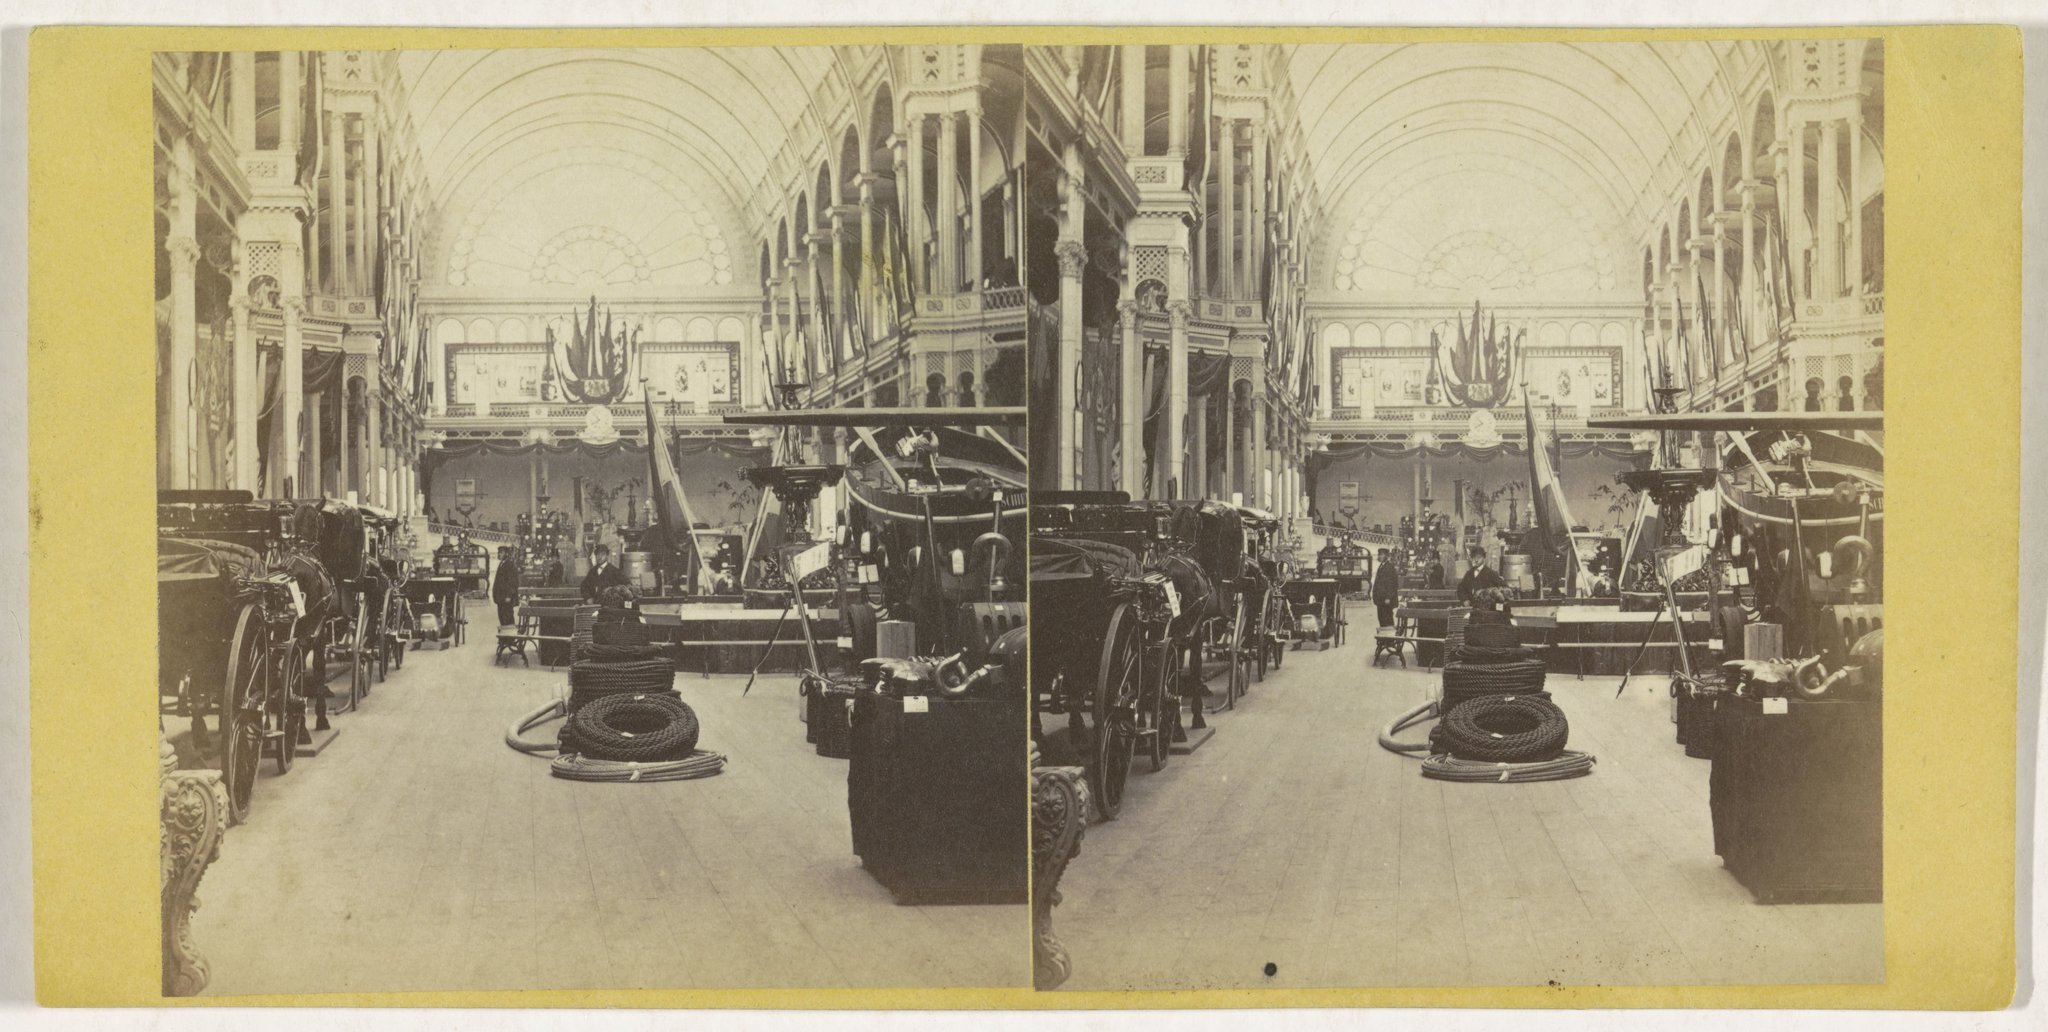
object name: stereograph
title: Koetsen en een boot bij de Tentoonstelling voor Nationale Nijverheid en Kunst in het Paleis voor Volksvlijt, Amsterdam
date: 1866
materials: cardboard, paper, photographic support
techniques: albumen print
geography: amsterdam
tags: paleis voor volksvlijt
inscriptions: stamp: ‘JDB’, label: ‘Boek & Kunsthandel Jan D. Brouwer, Kalverstraat E, Nº 37 Amsterdam.’